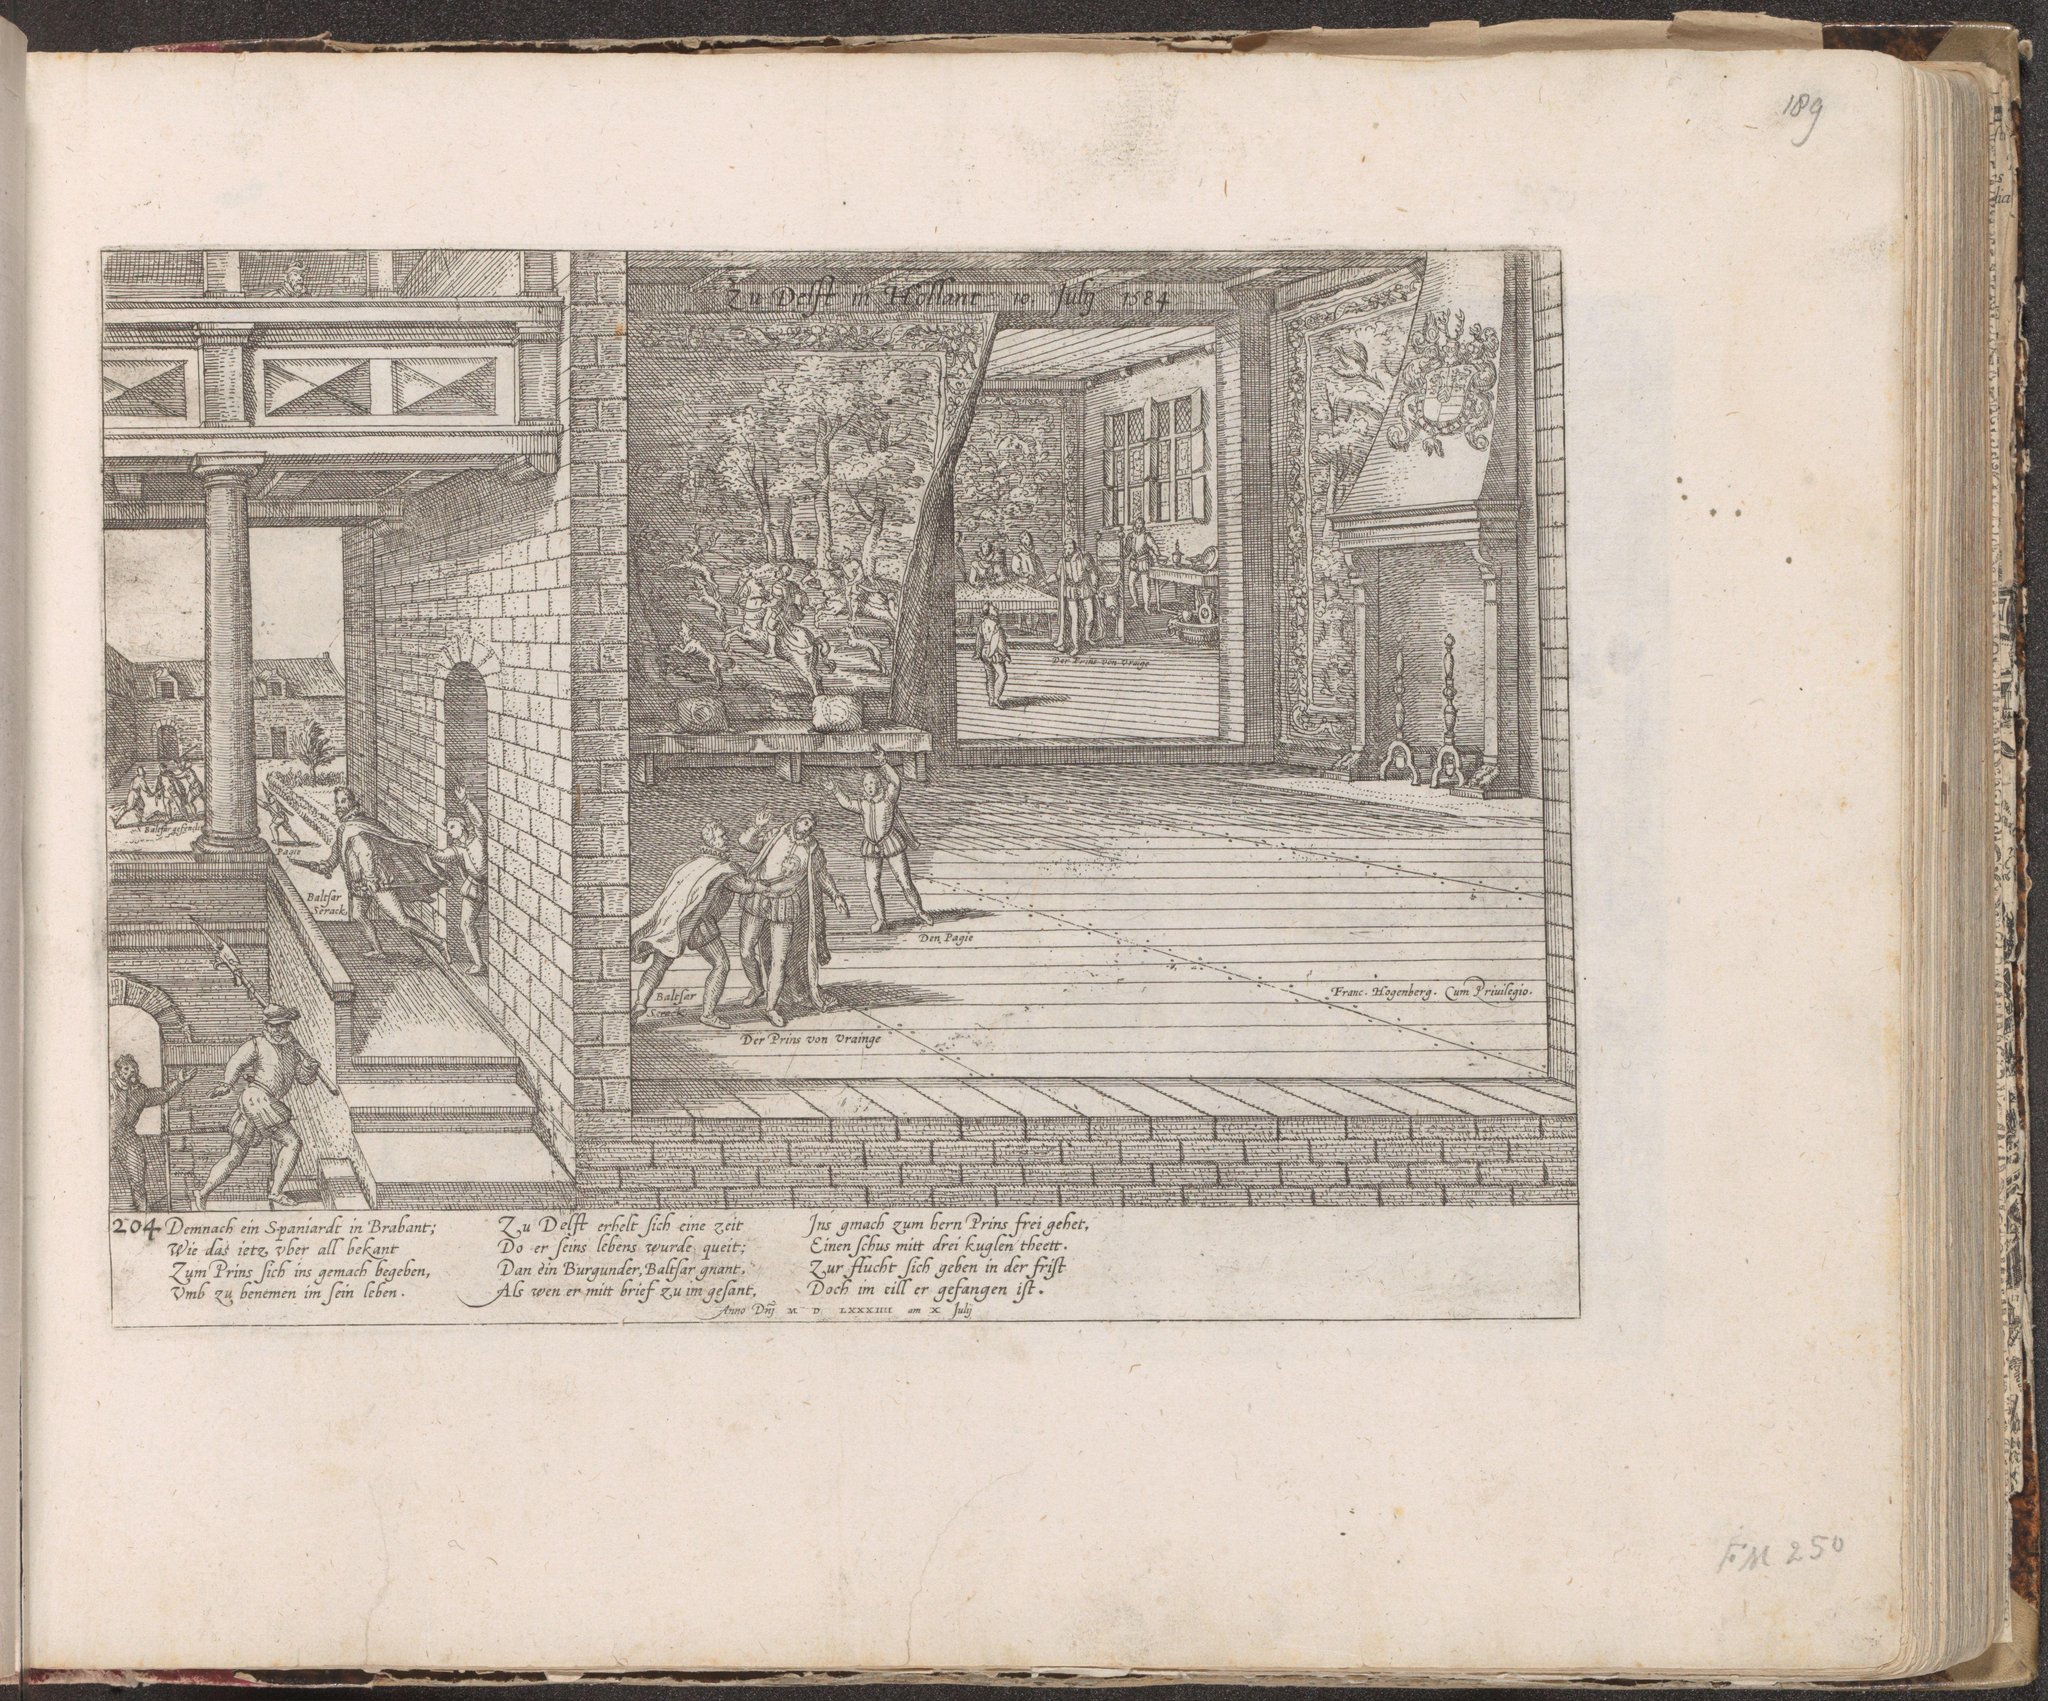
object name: album leaf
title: Zu Delft in Hollant 10 Julij 1584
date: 1587-1591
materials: paper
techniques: etching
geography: cologne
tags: delft, william i (prince of orange), attempt, political murder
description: Willem van Oranje vermoord door Balthasar Gerards, 10 juli 1584. Gezicht op interieur Prinsenhof: achter ontvangt de prins Gerards in een kamer, op de voorgrond wordt de prins neergeschoten. Links probeert Gerards te ontsnappen en wordt hij gevangengenomen. Met onderschrift van 12 regels in het Duits. Linksonder genummerd: 204. De prent maakt deel uit van een album.